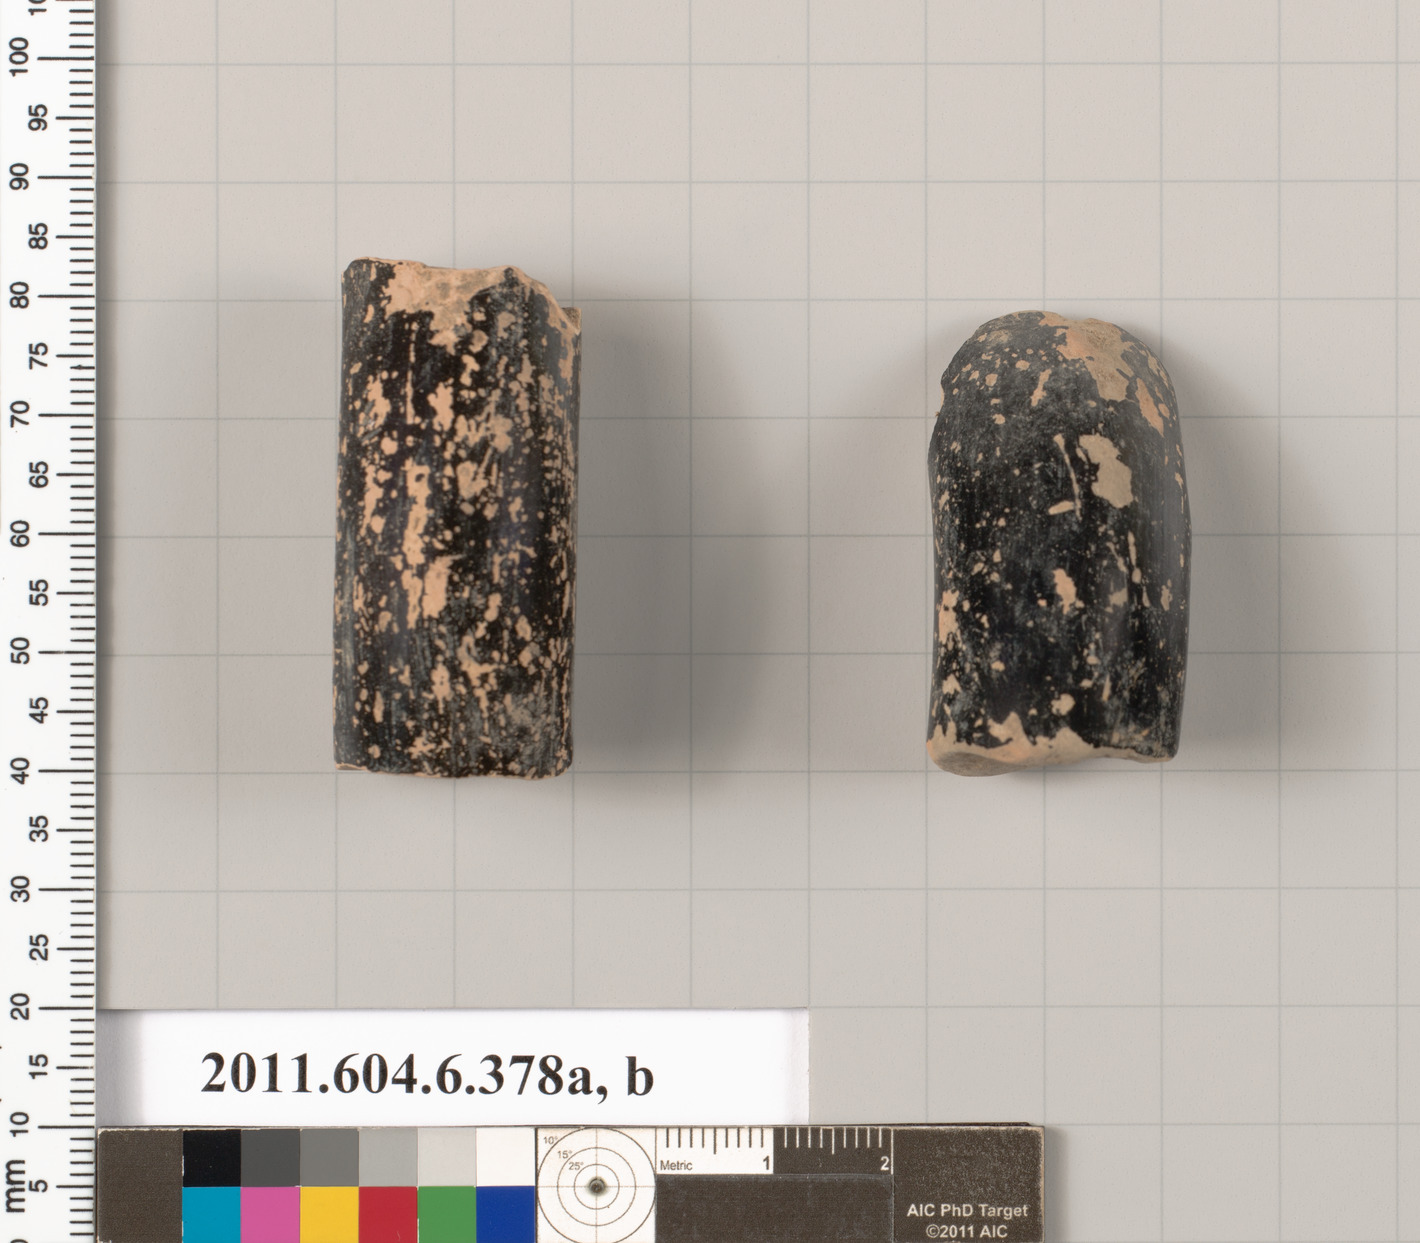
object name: undetermined shape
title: Terracotta fragments of undetermined shapes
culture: greek, attic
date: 600-401 BCE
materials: terracotta